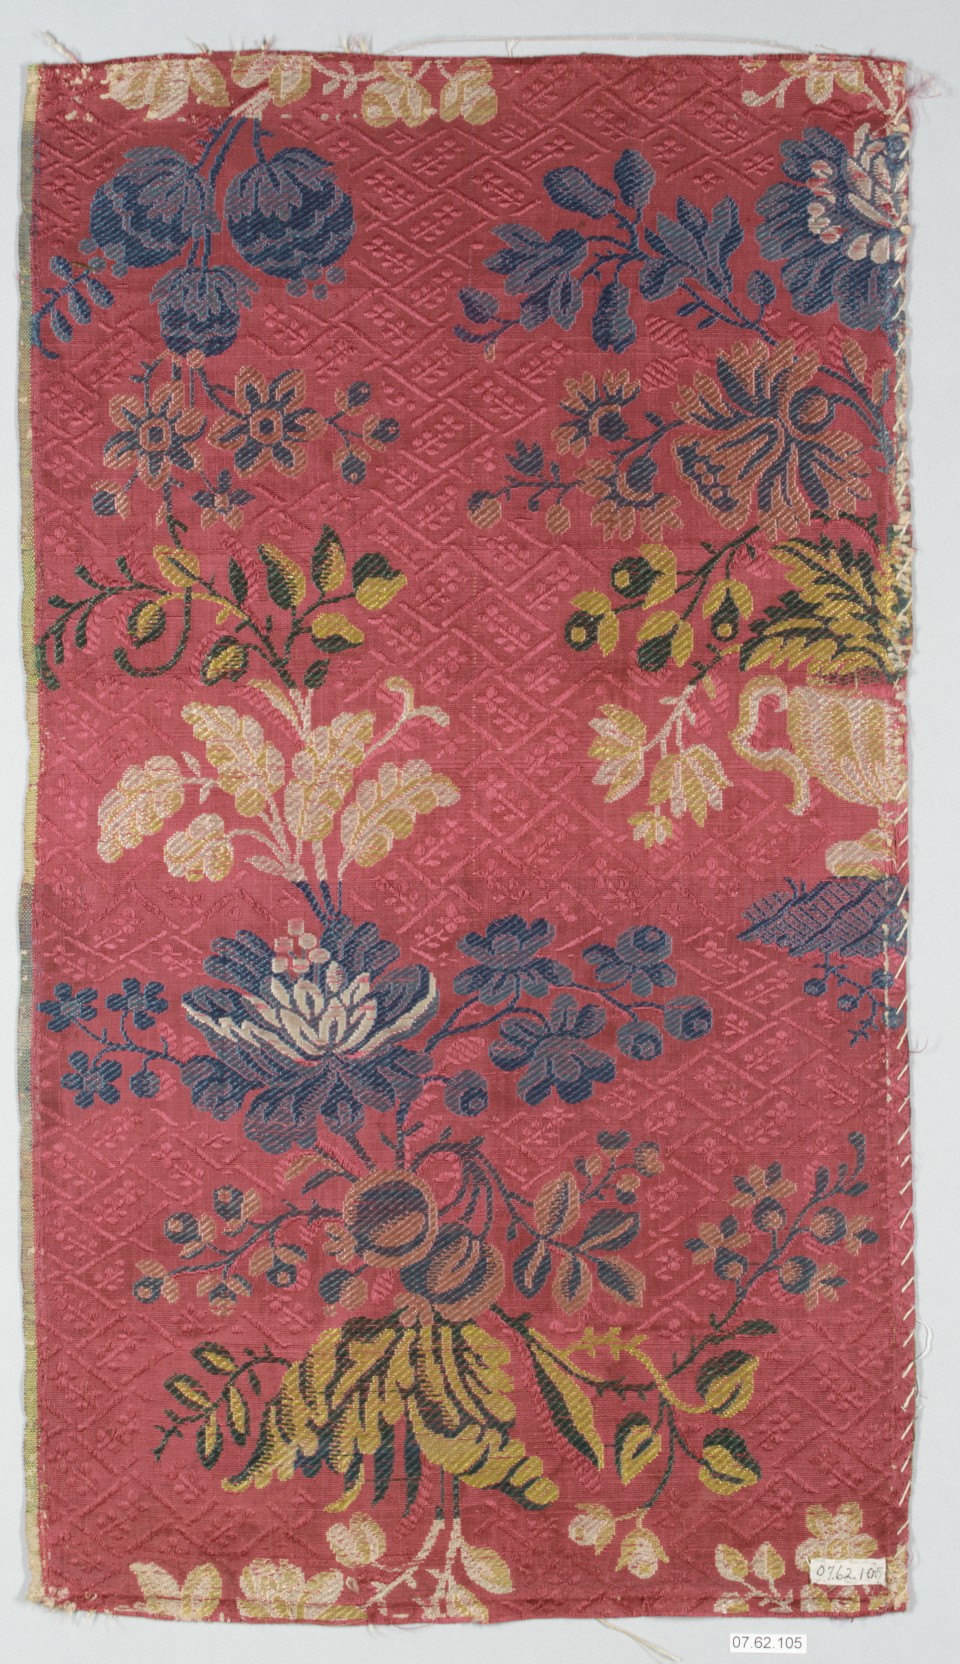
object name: piece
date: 1730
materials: silk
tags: flowers,leaves